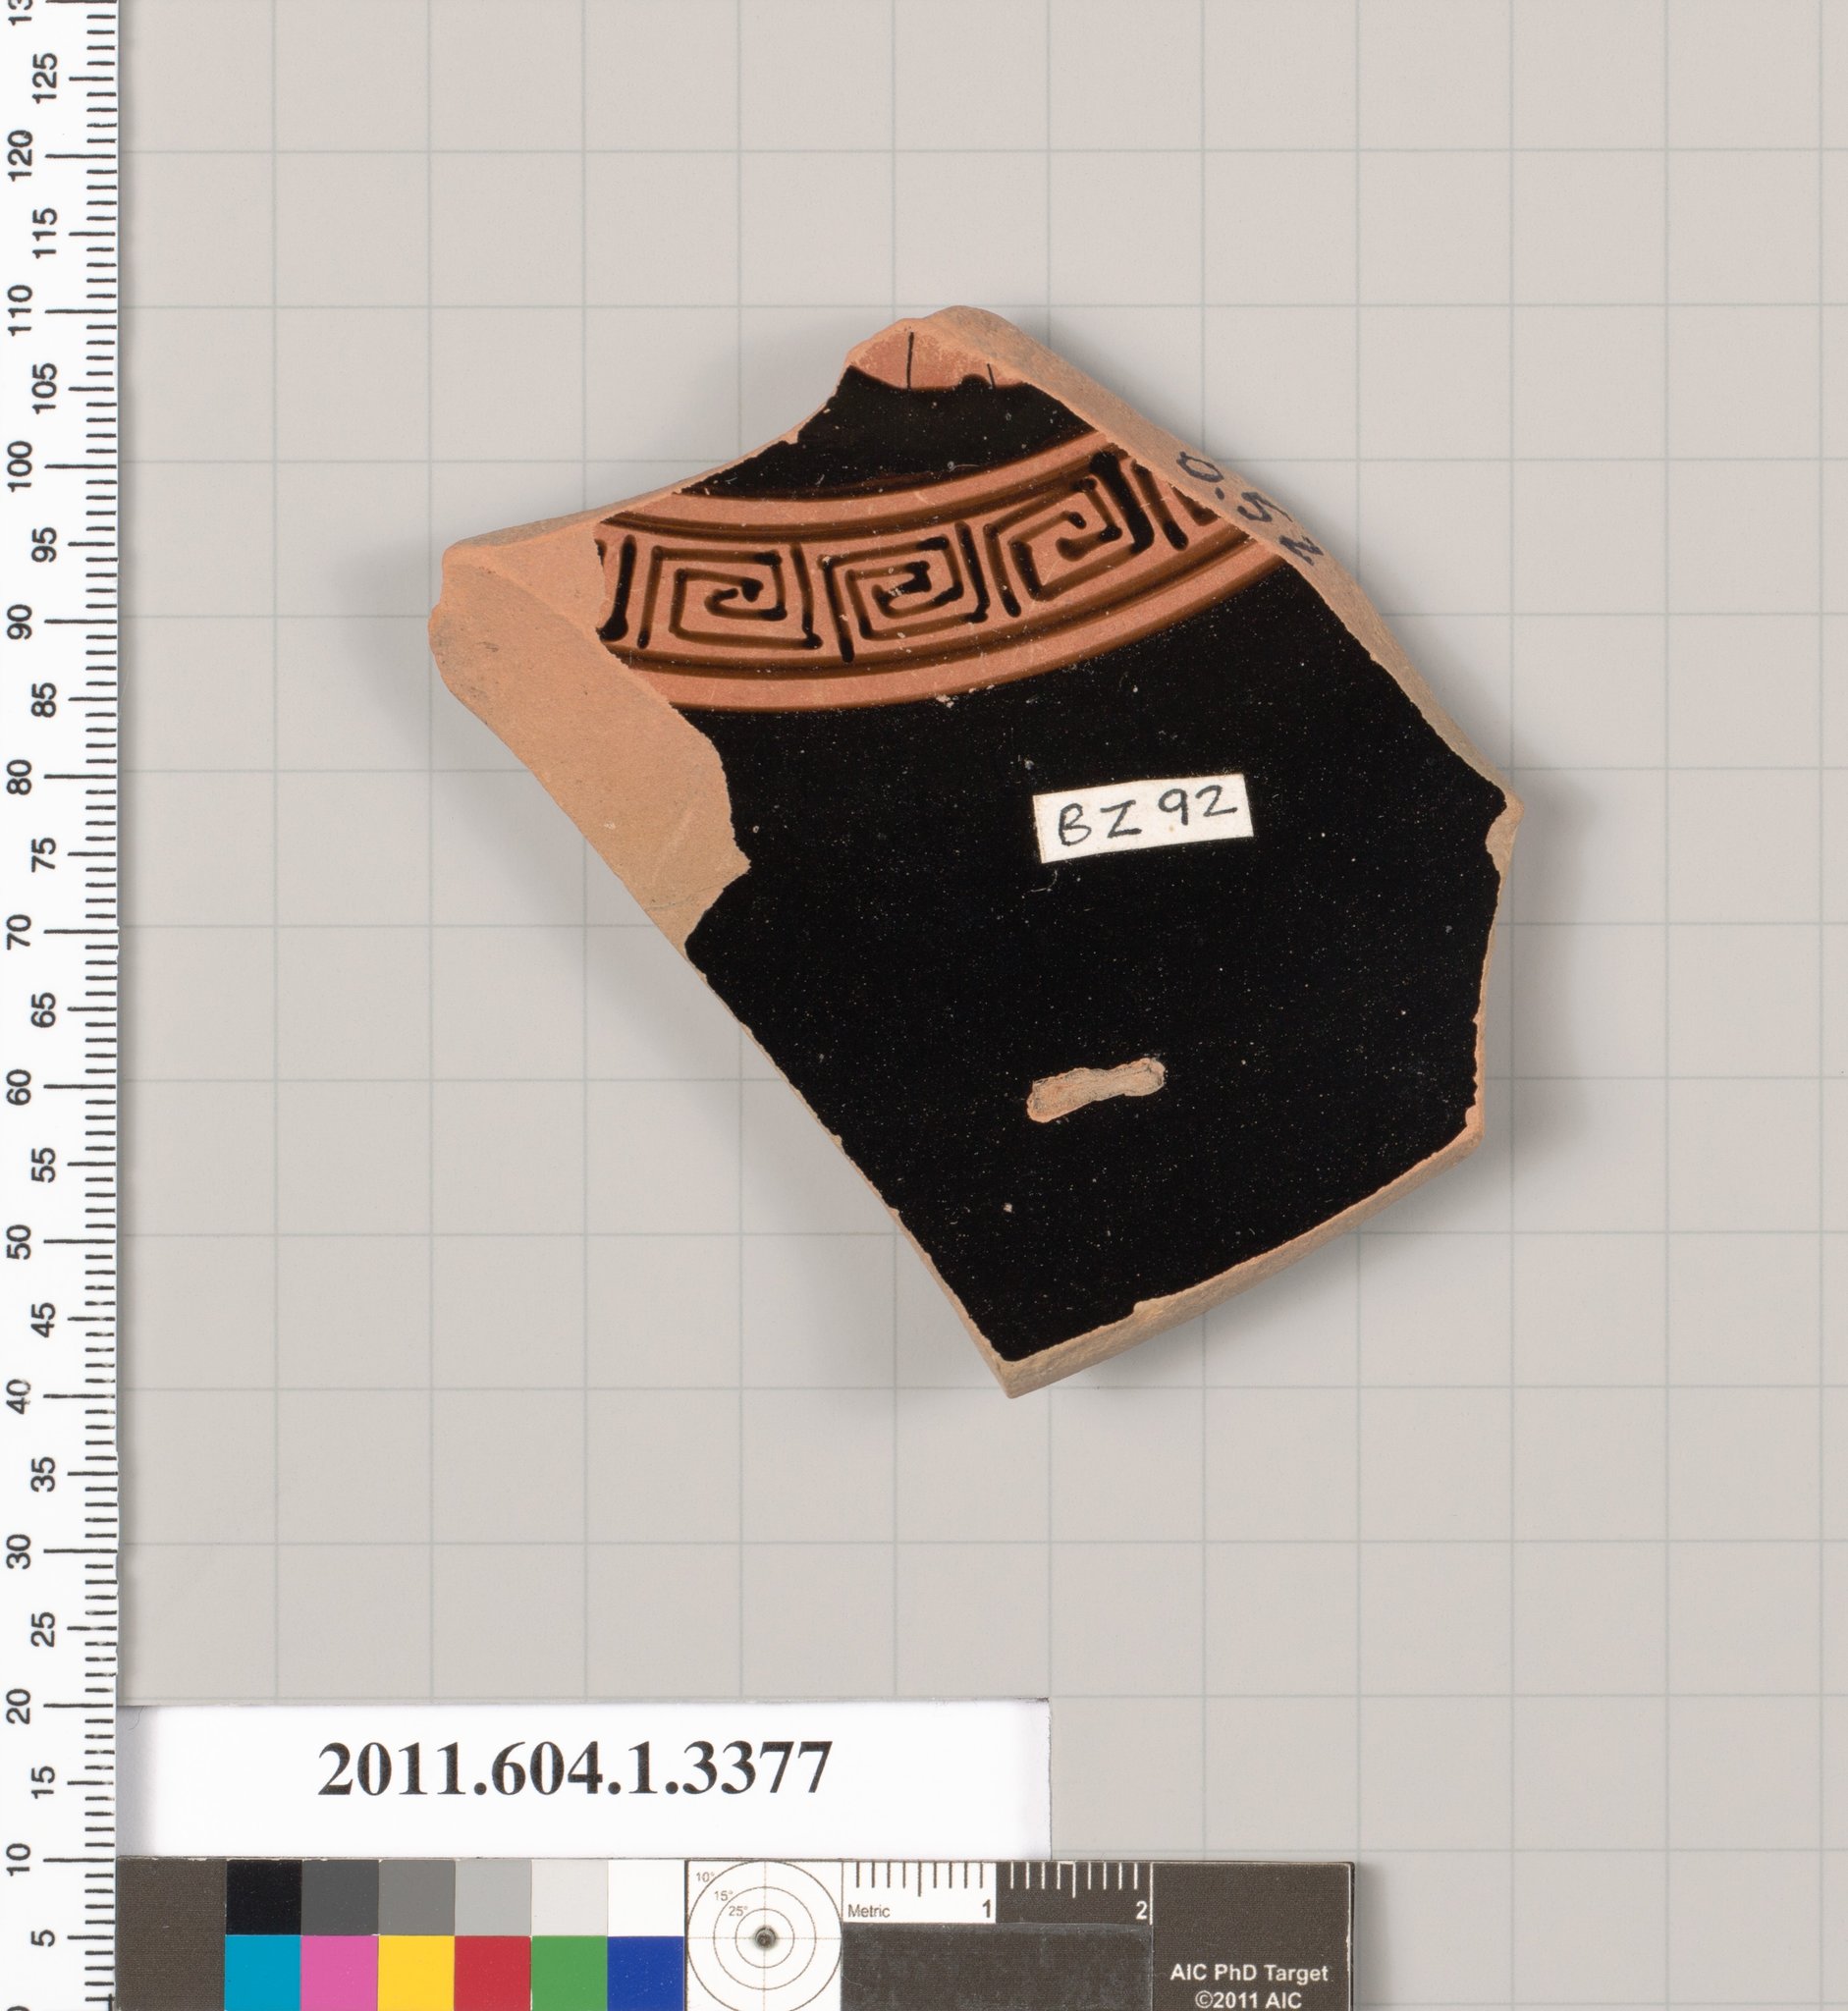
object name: kylix fragment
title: Terracotta fragment of a kylix (drinking cup)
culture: greek, attic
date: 475-451 BCE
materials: terracotta